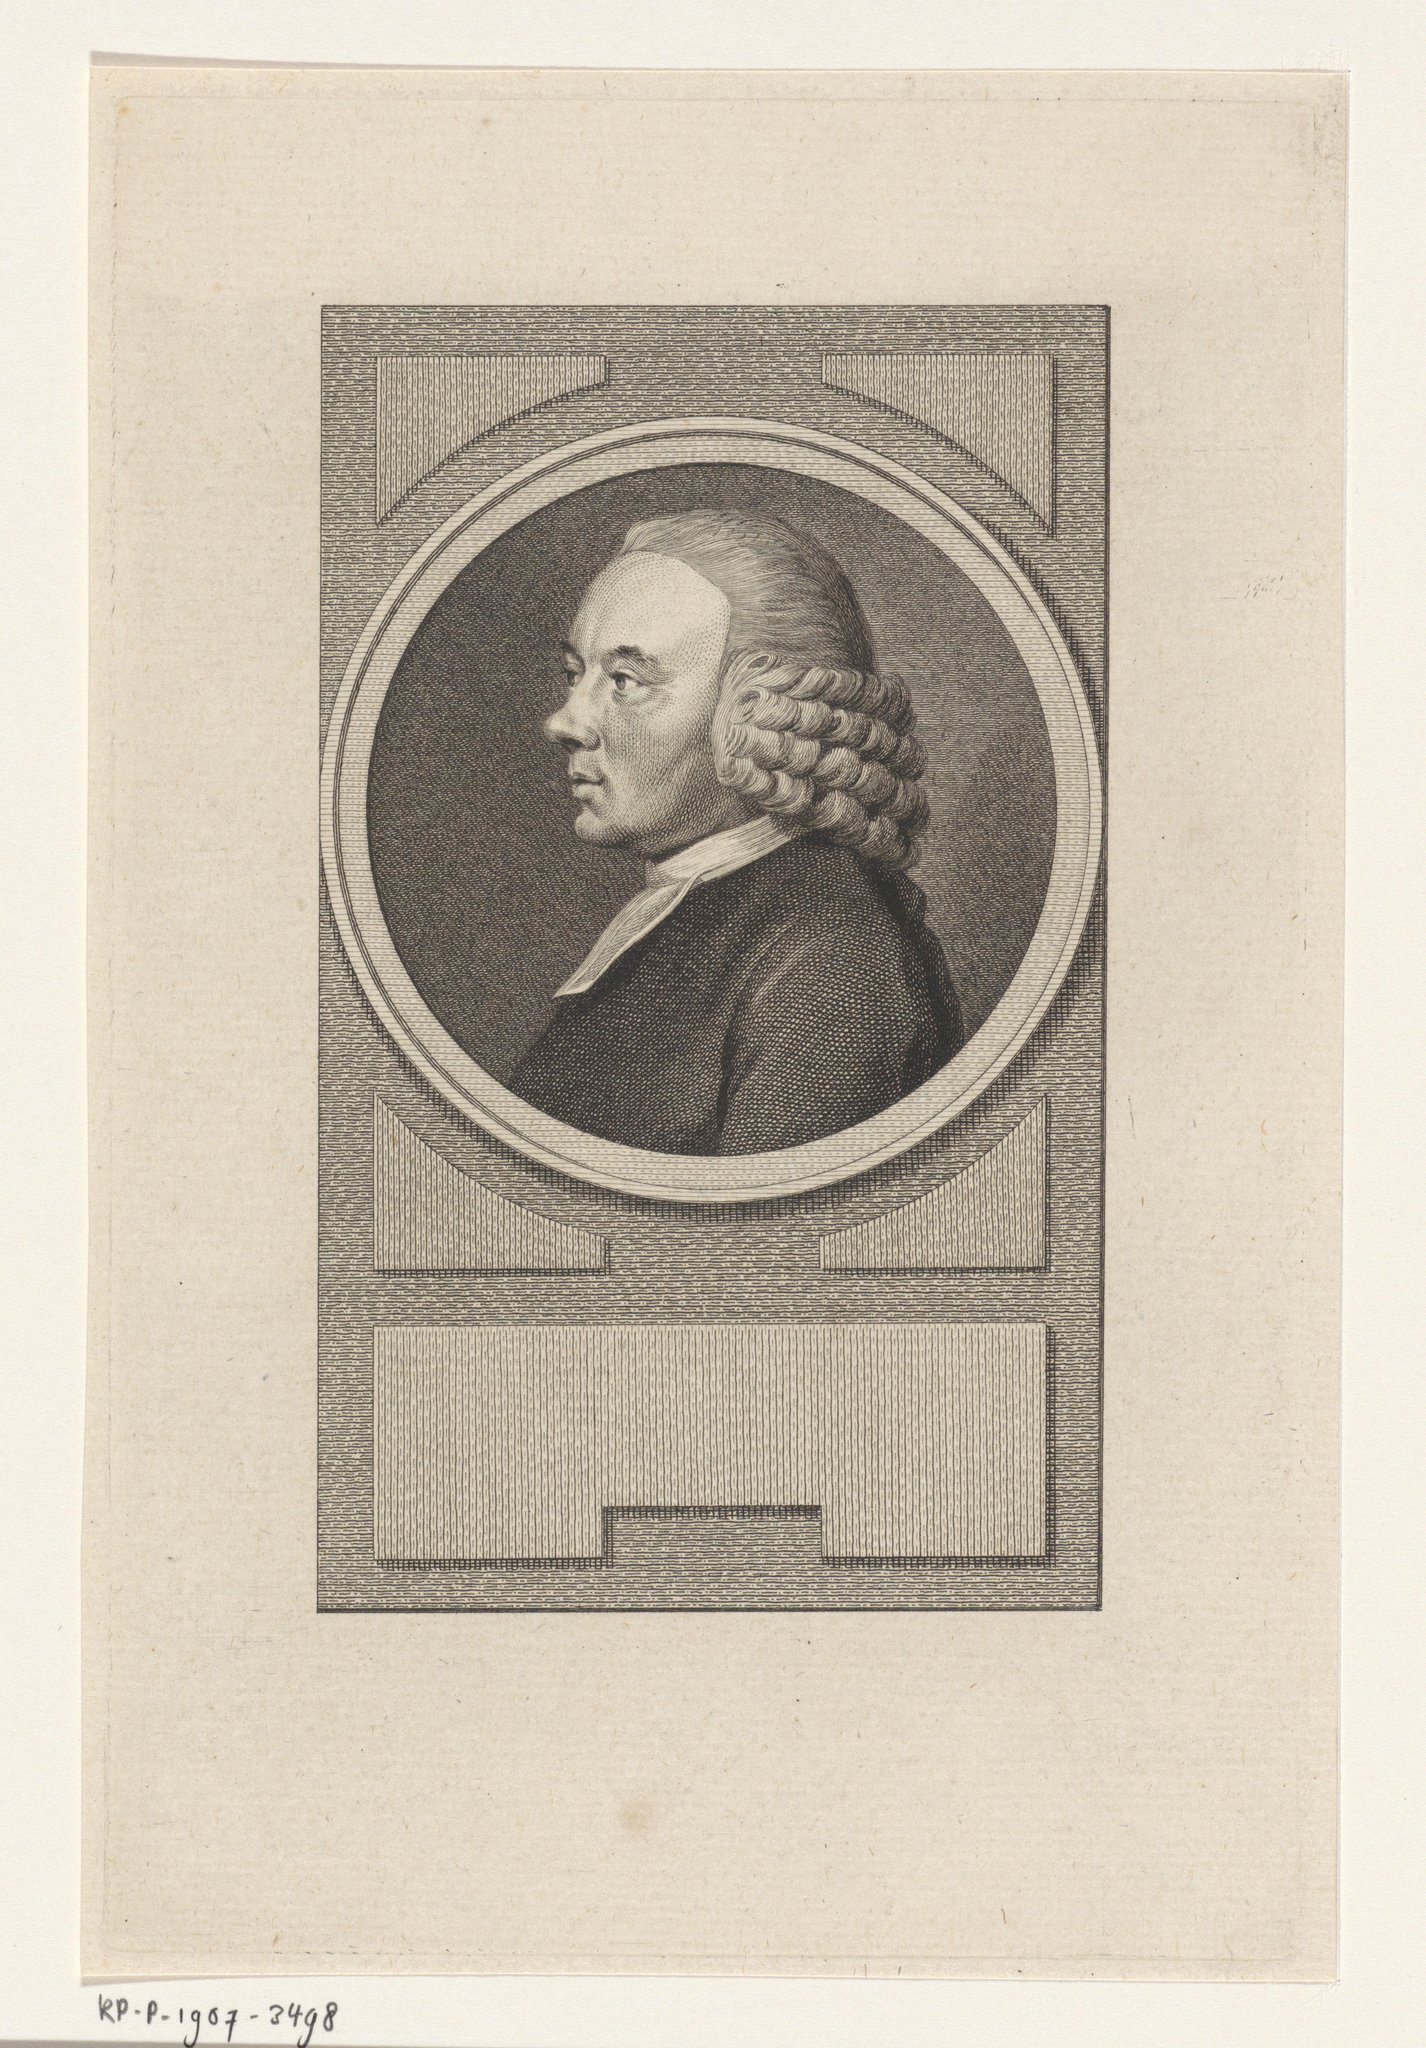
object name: print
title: Portret van Engelbertus Matthias Engelberts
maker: reinier vinkeles (i)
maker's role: draughtsman, print maker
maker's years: 1741-1816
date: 1784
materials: paper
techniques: engraving, etching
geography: amsterdam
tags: hoorn (north holland), engelbertus matthias engelberts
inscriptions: collector's mark: Lugt 2228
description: Portret van Engelbertus Matthias Engelberts, predikant te Hoorn en tekenaar.